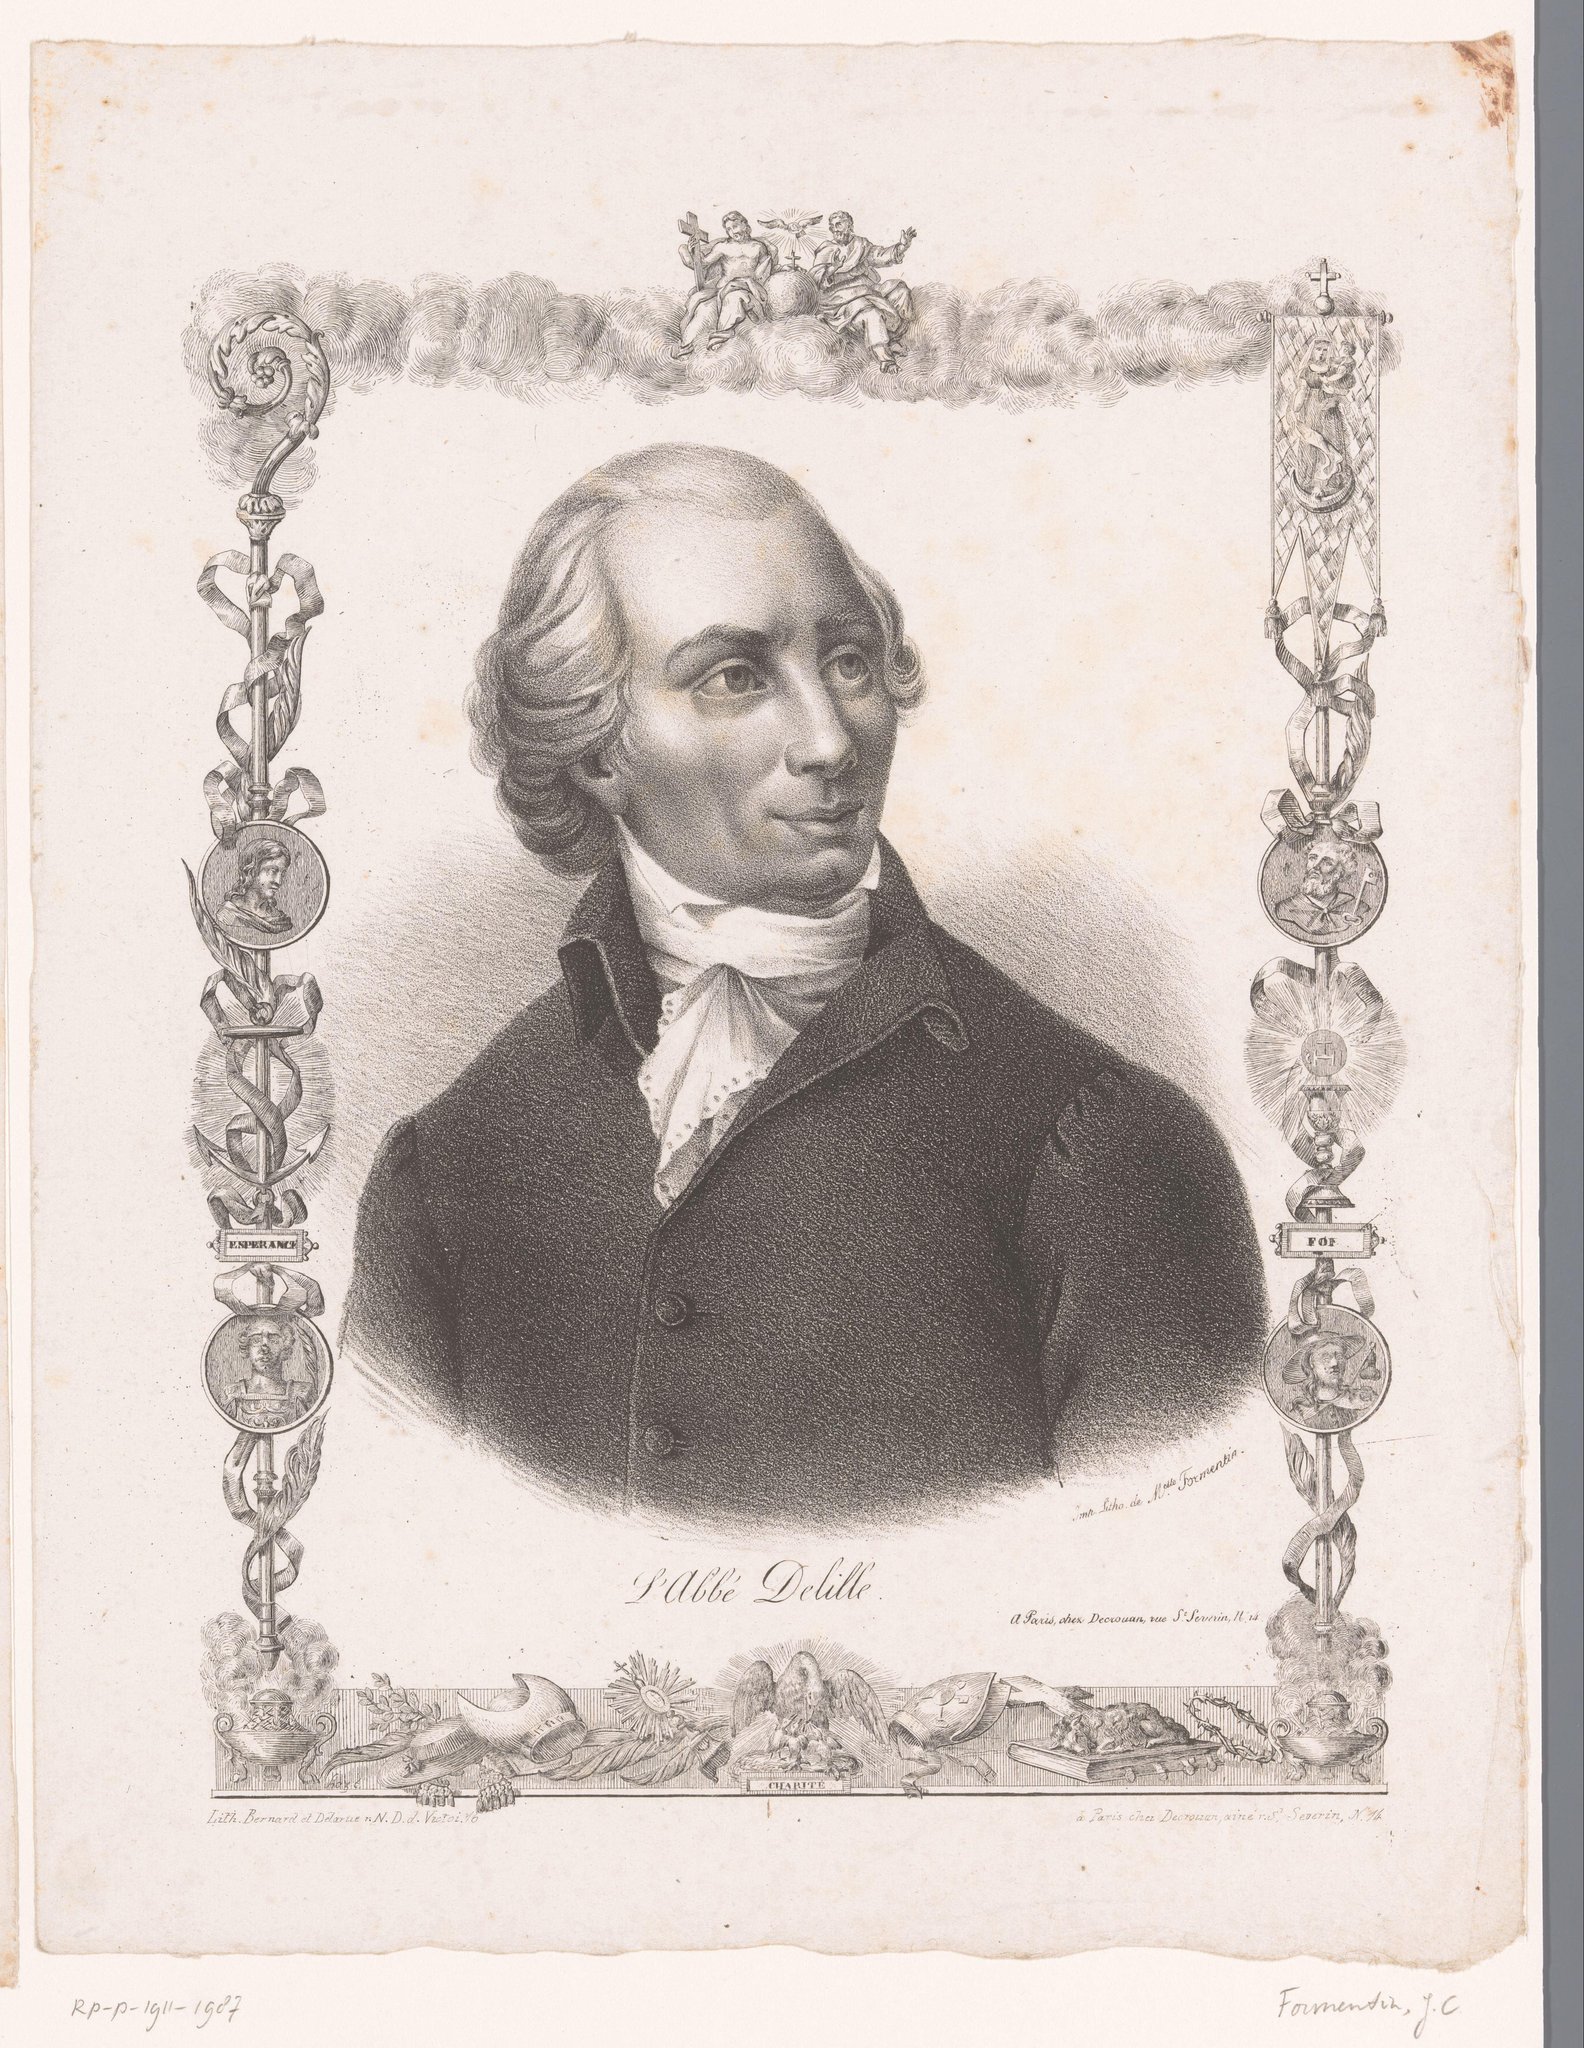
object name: print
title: L'Abbé Delille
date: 1826-1829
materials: paper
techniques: lithograph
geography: paris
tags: paris, jacques delille, historical persons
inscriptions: collector's mark: Lugt 2228a